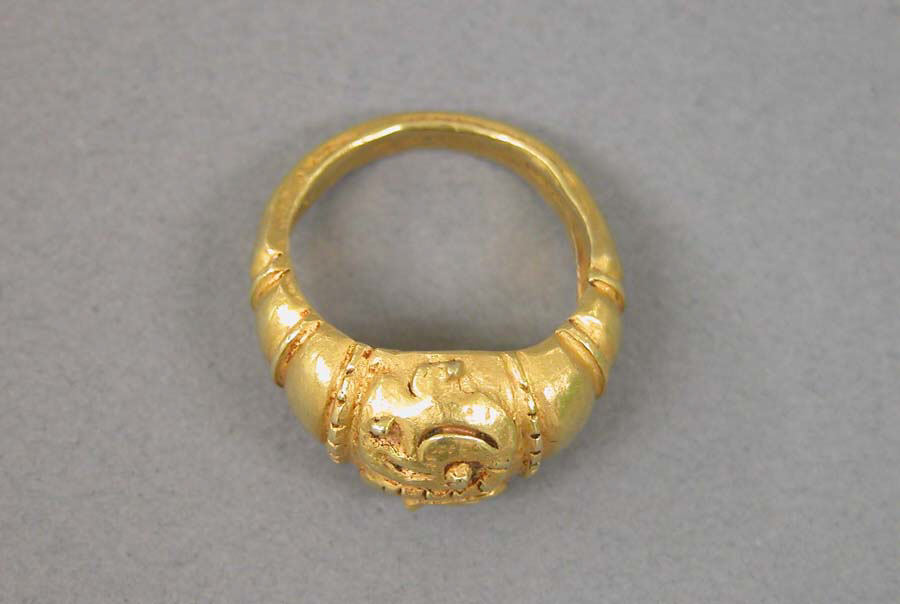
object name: ring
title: Ring with Scroll Pattern Design on Bezel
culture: indonesian, javanese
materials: gold